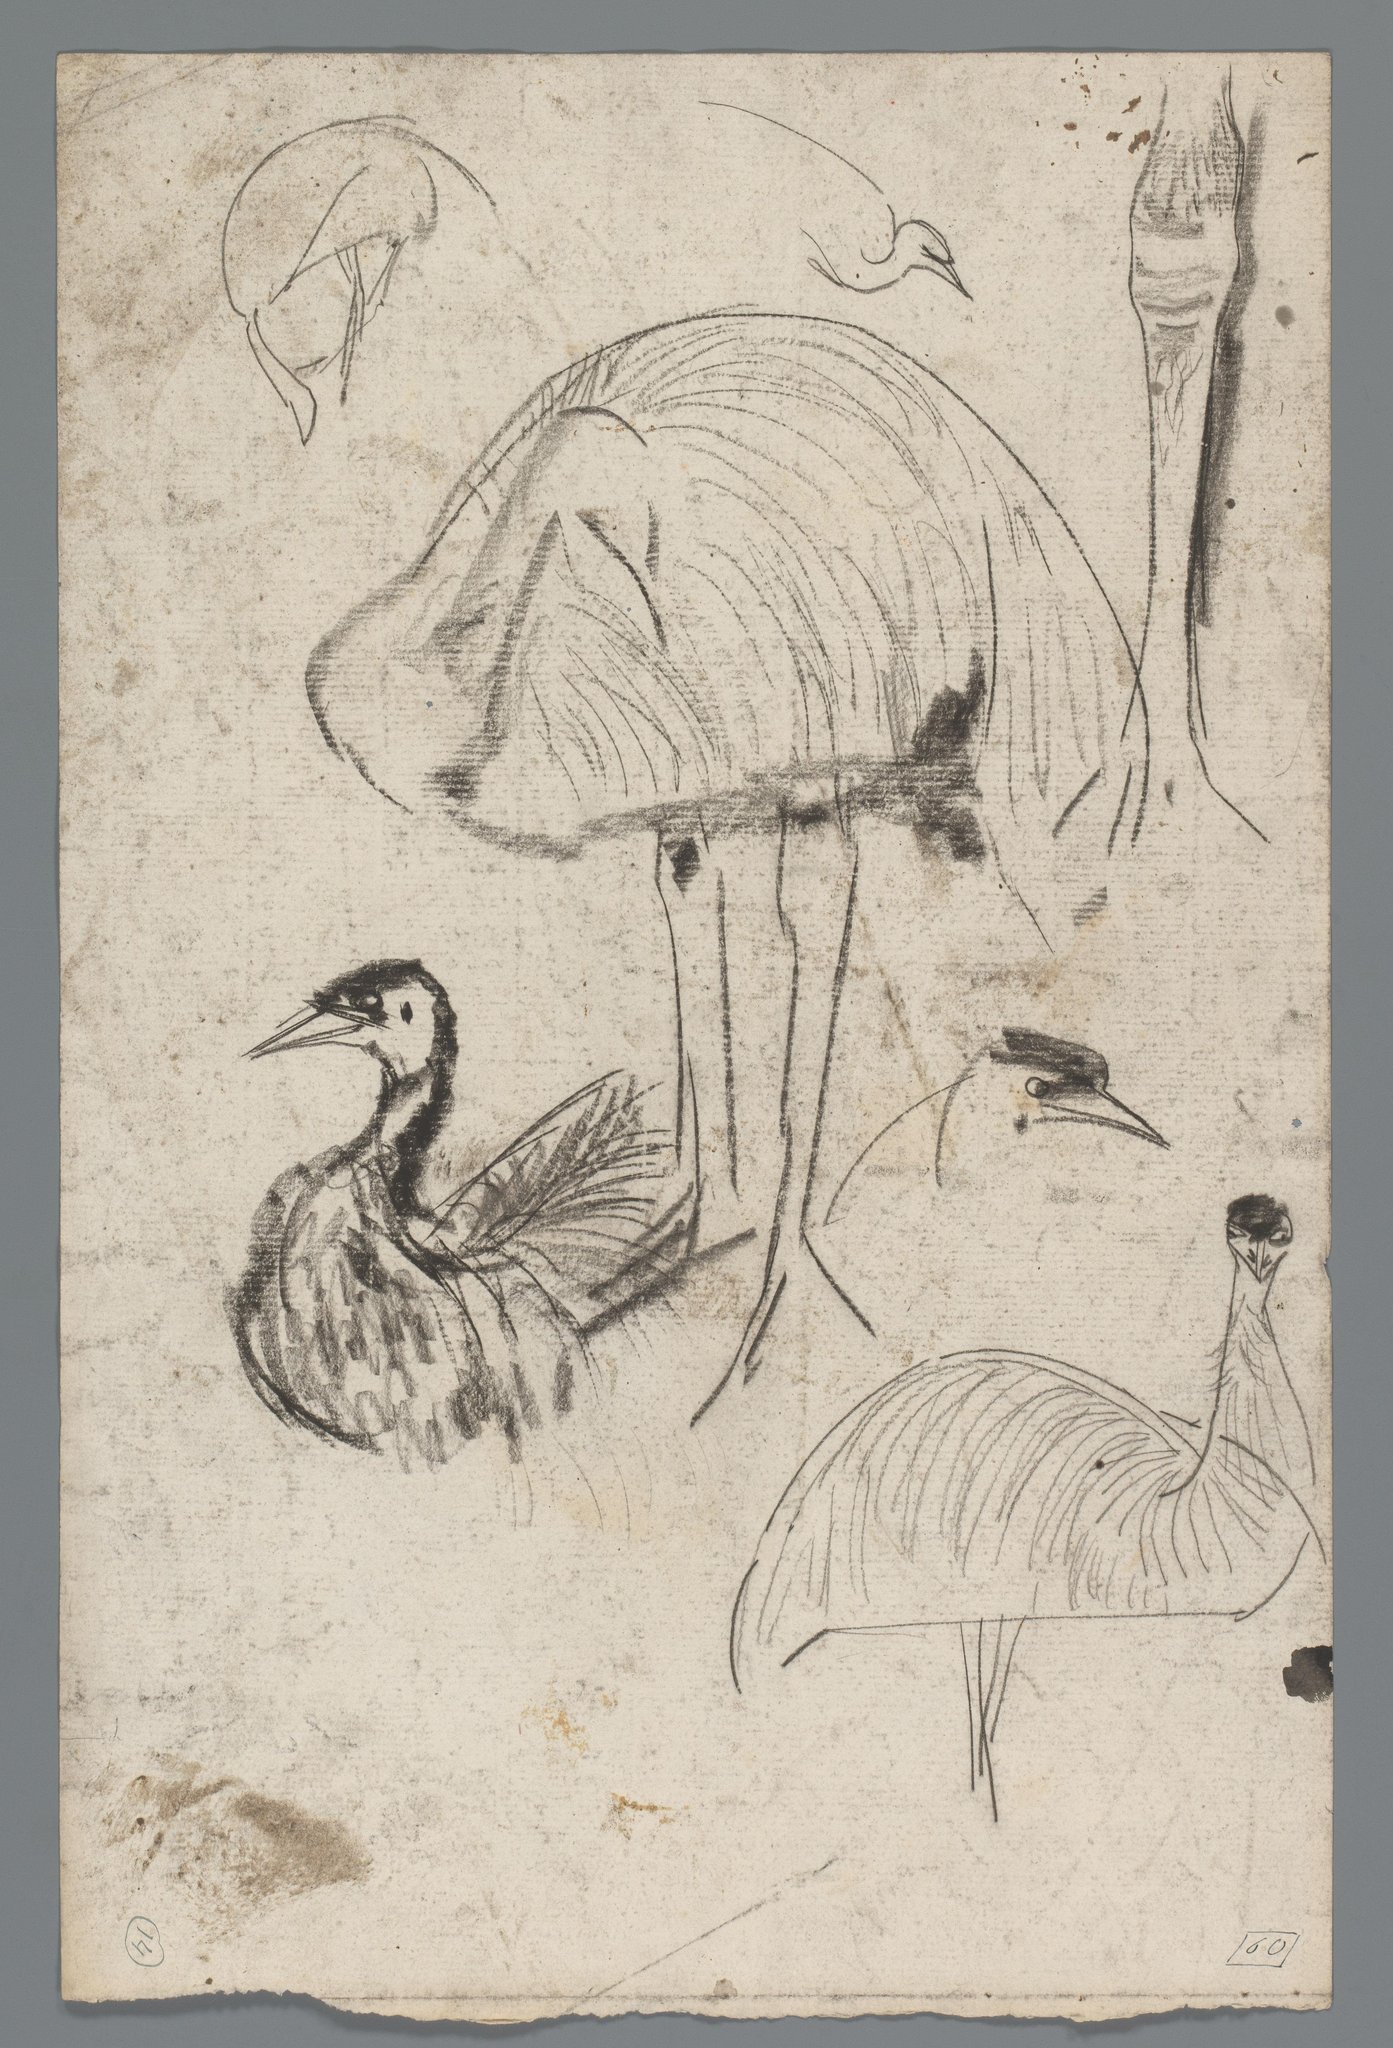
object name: drawing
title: Studies van een emoe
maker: gerrit willem dijsselhof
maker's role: designer, draughtsman, print maker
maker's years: 1866-1924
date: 1876-1924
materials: chalk, paper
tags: walker and runner birds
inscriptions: number: ‘60’